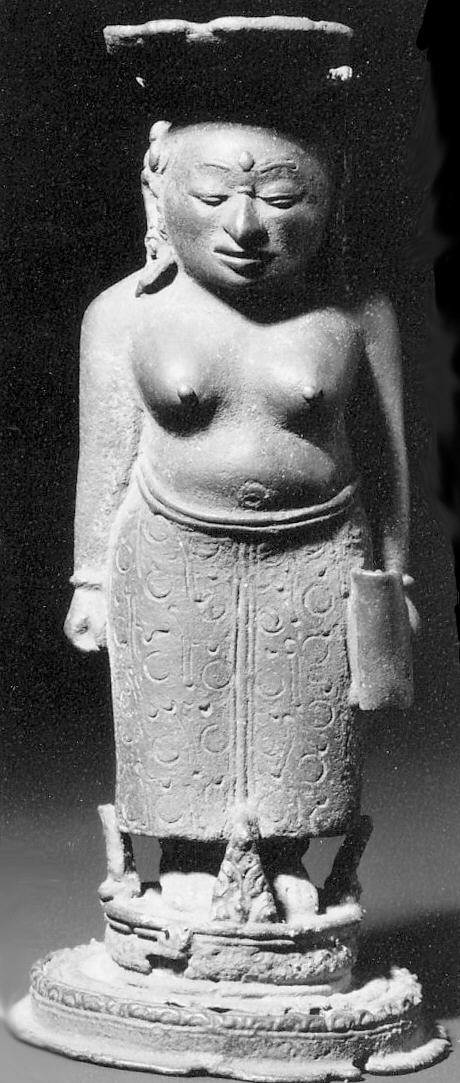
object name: figure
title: Standing Female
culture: indonesian, javanese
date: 1301-1400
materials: bronze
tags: female nudes